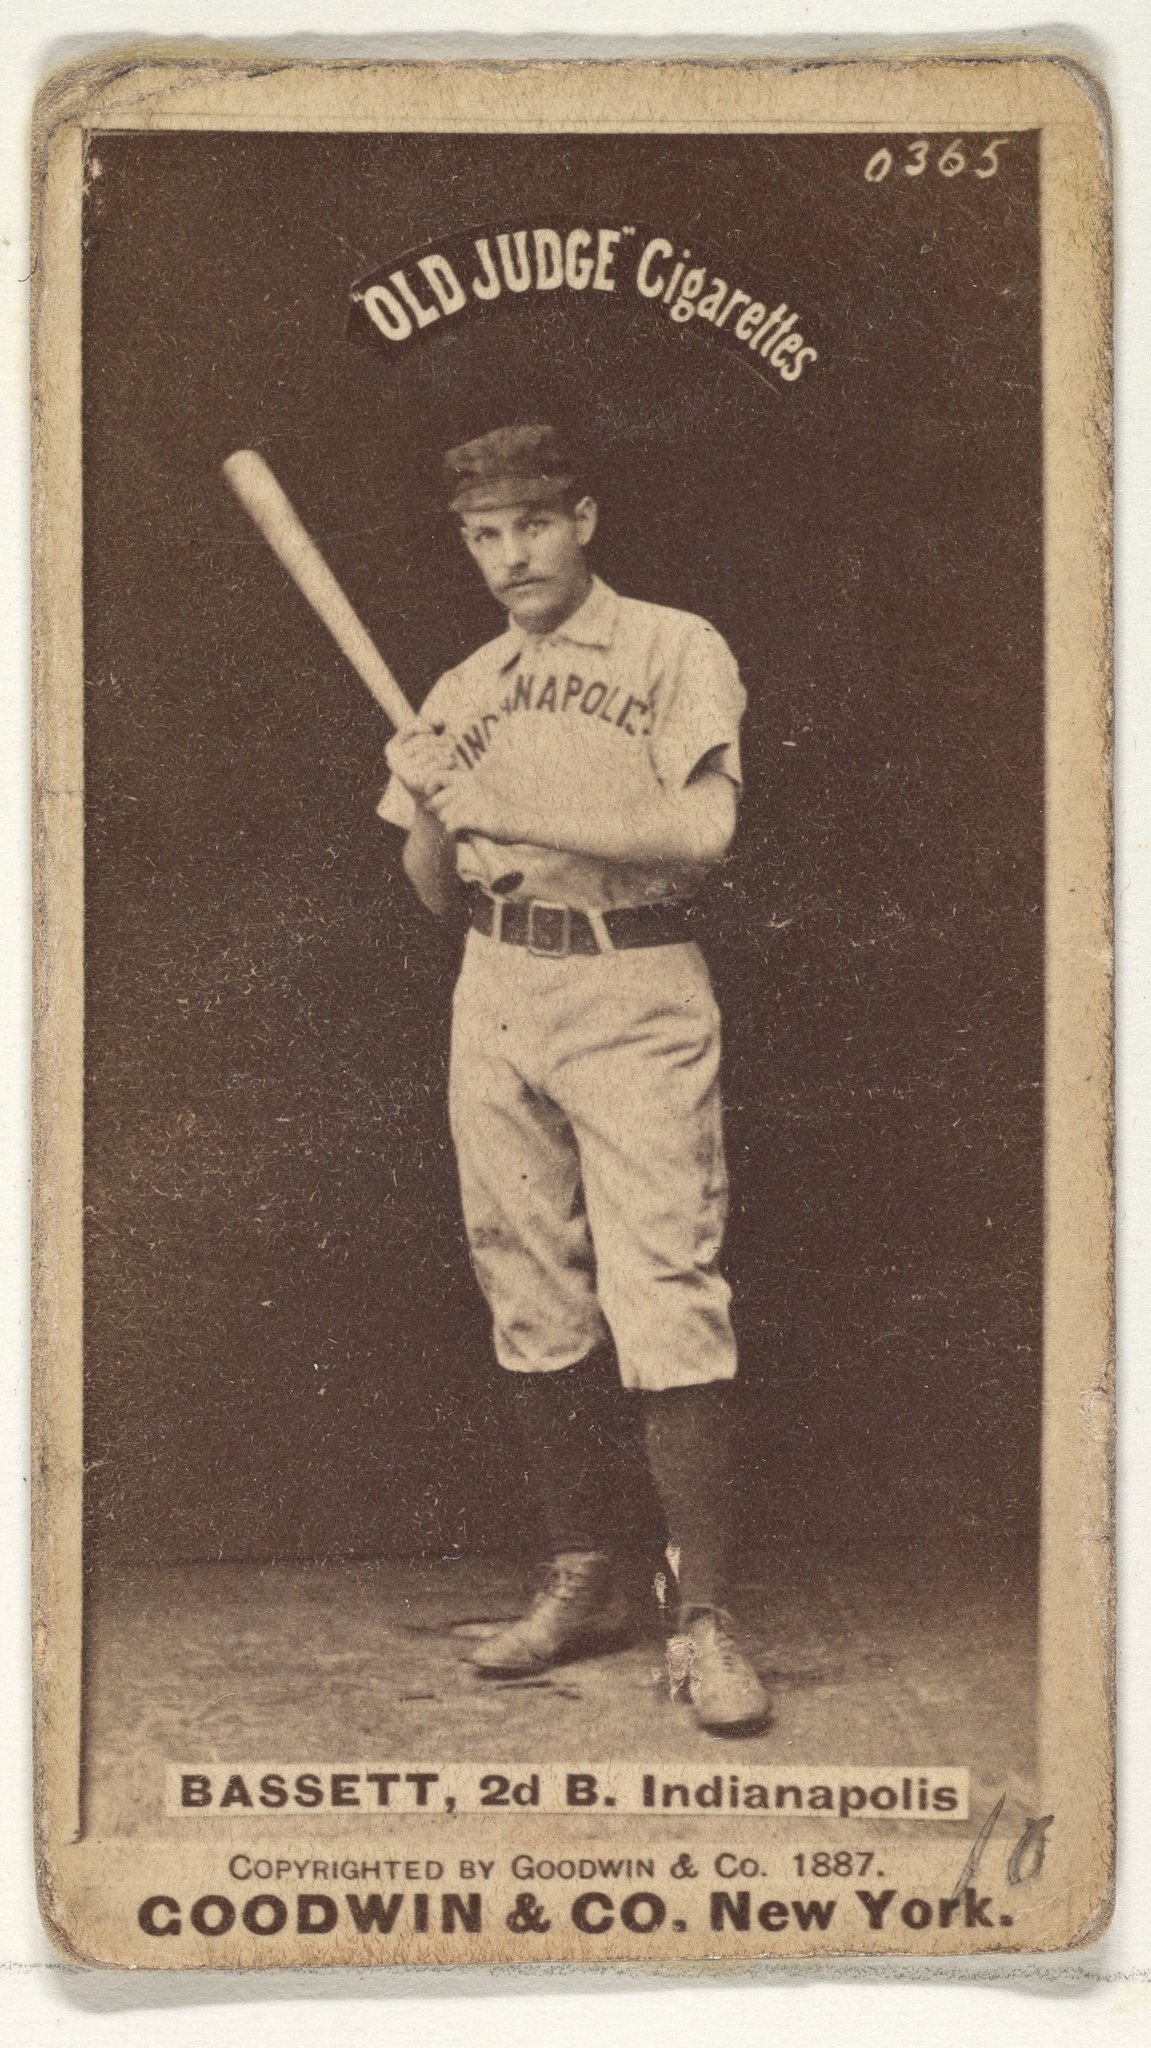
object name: baseball card, photograph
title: Bassett, 2nd Base, Indianapolis, from the Old Judge series (N172) for Old Judge Cigarettes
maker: goodwin & company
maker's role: publisher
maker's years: 1850-1950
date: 1887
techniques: albumen silver print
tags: men,portraits,baseball,athletes